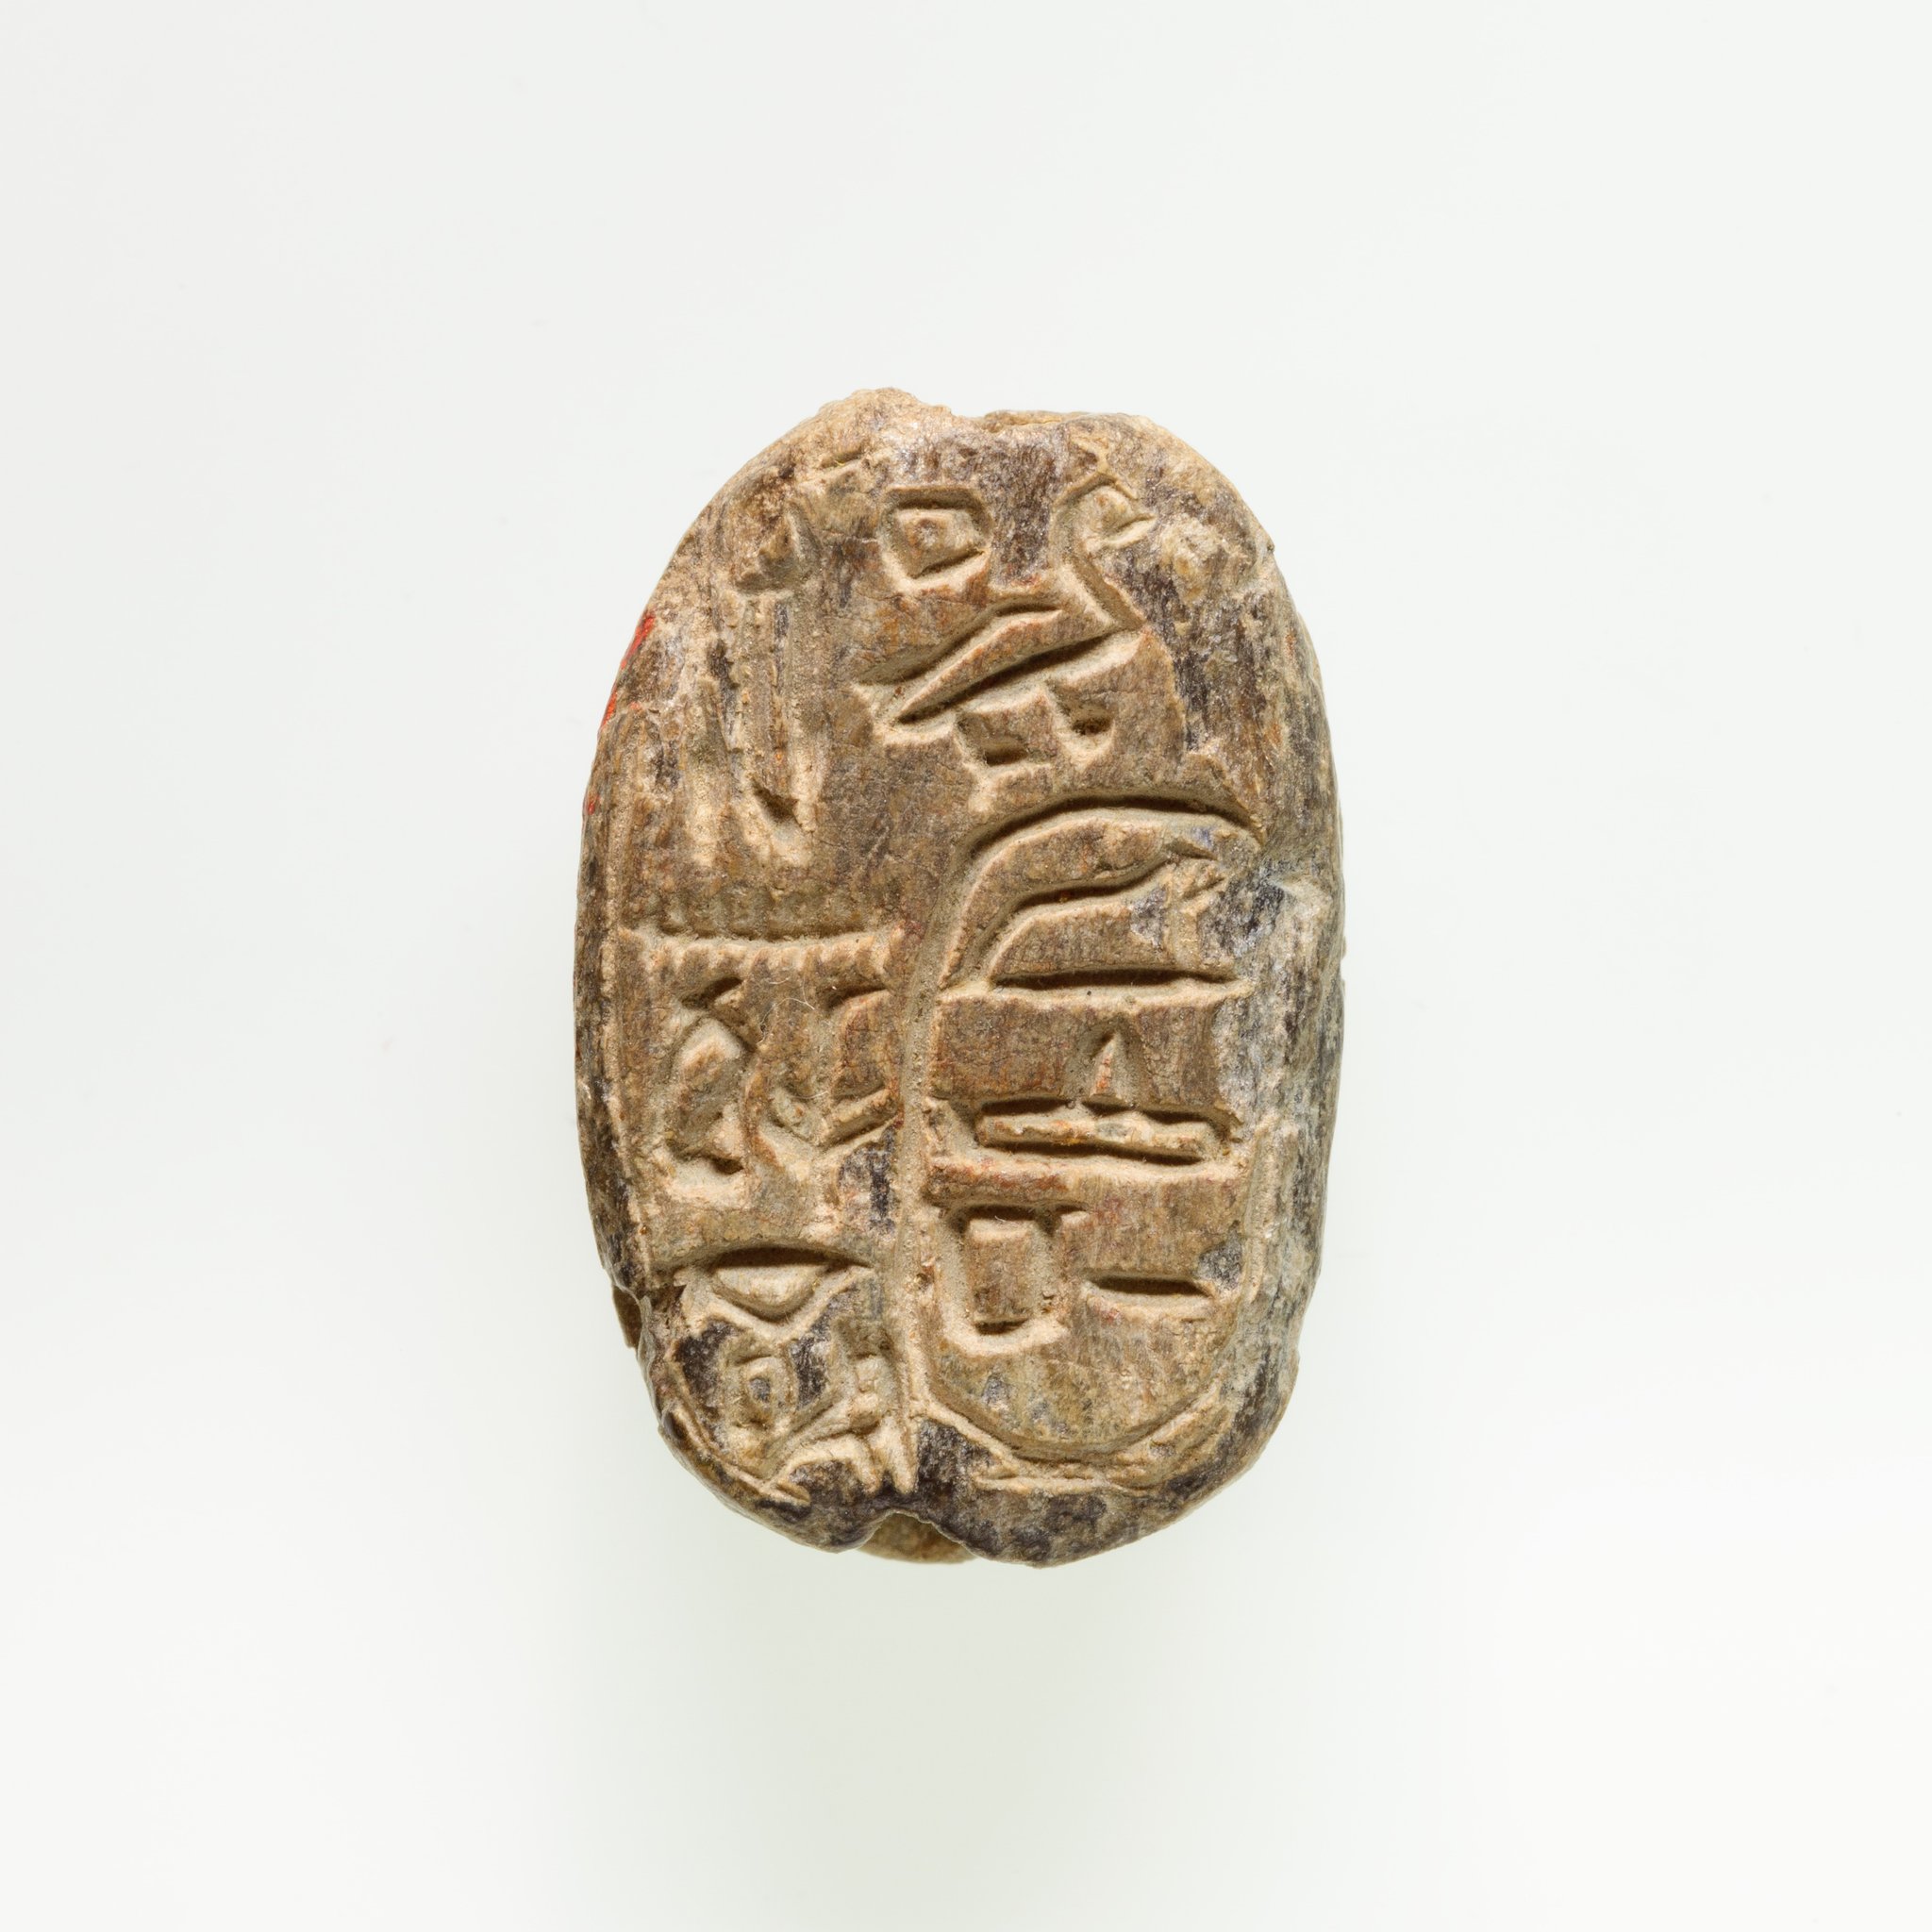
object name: scarab, sebekhotep iv, hieroglyph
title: Scarab of Sebekhotep IV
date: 1731-1719 BCE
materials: stone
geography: egypt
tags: hieroglyphs,scarabs